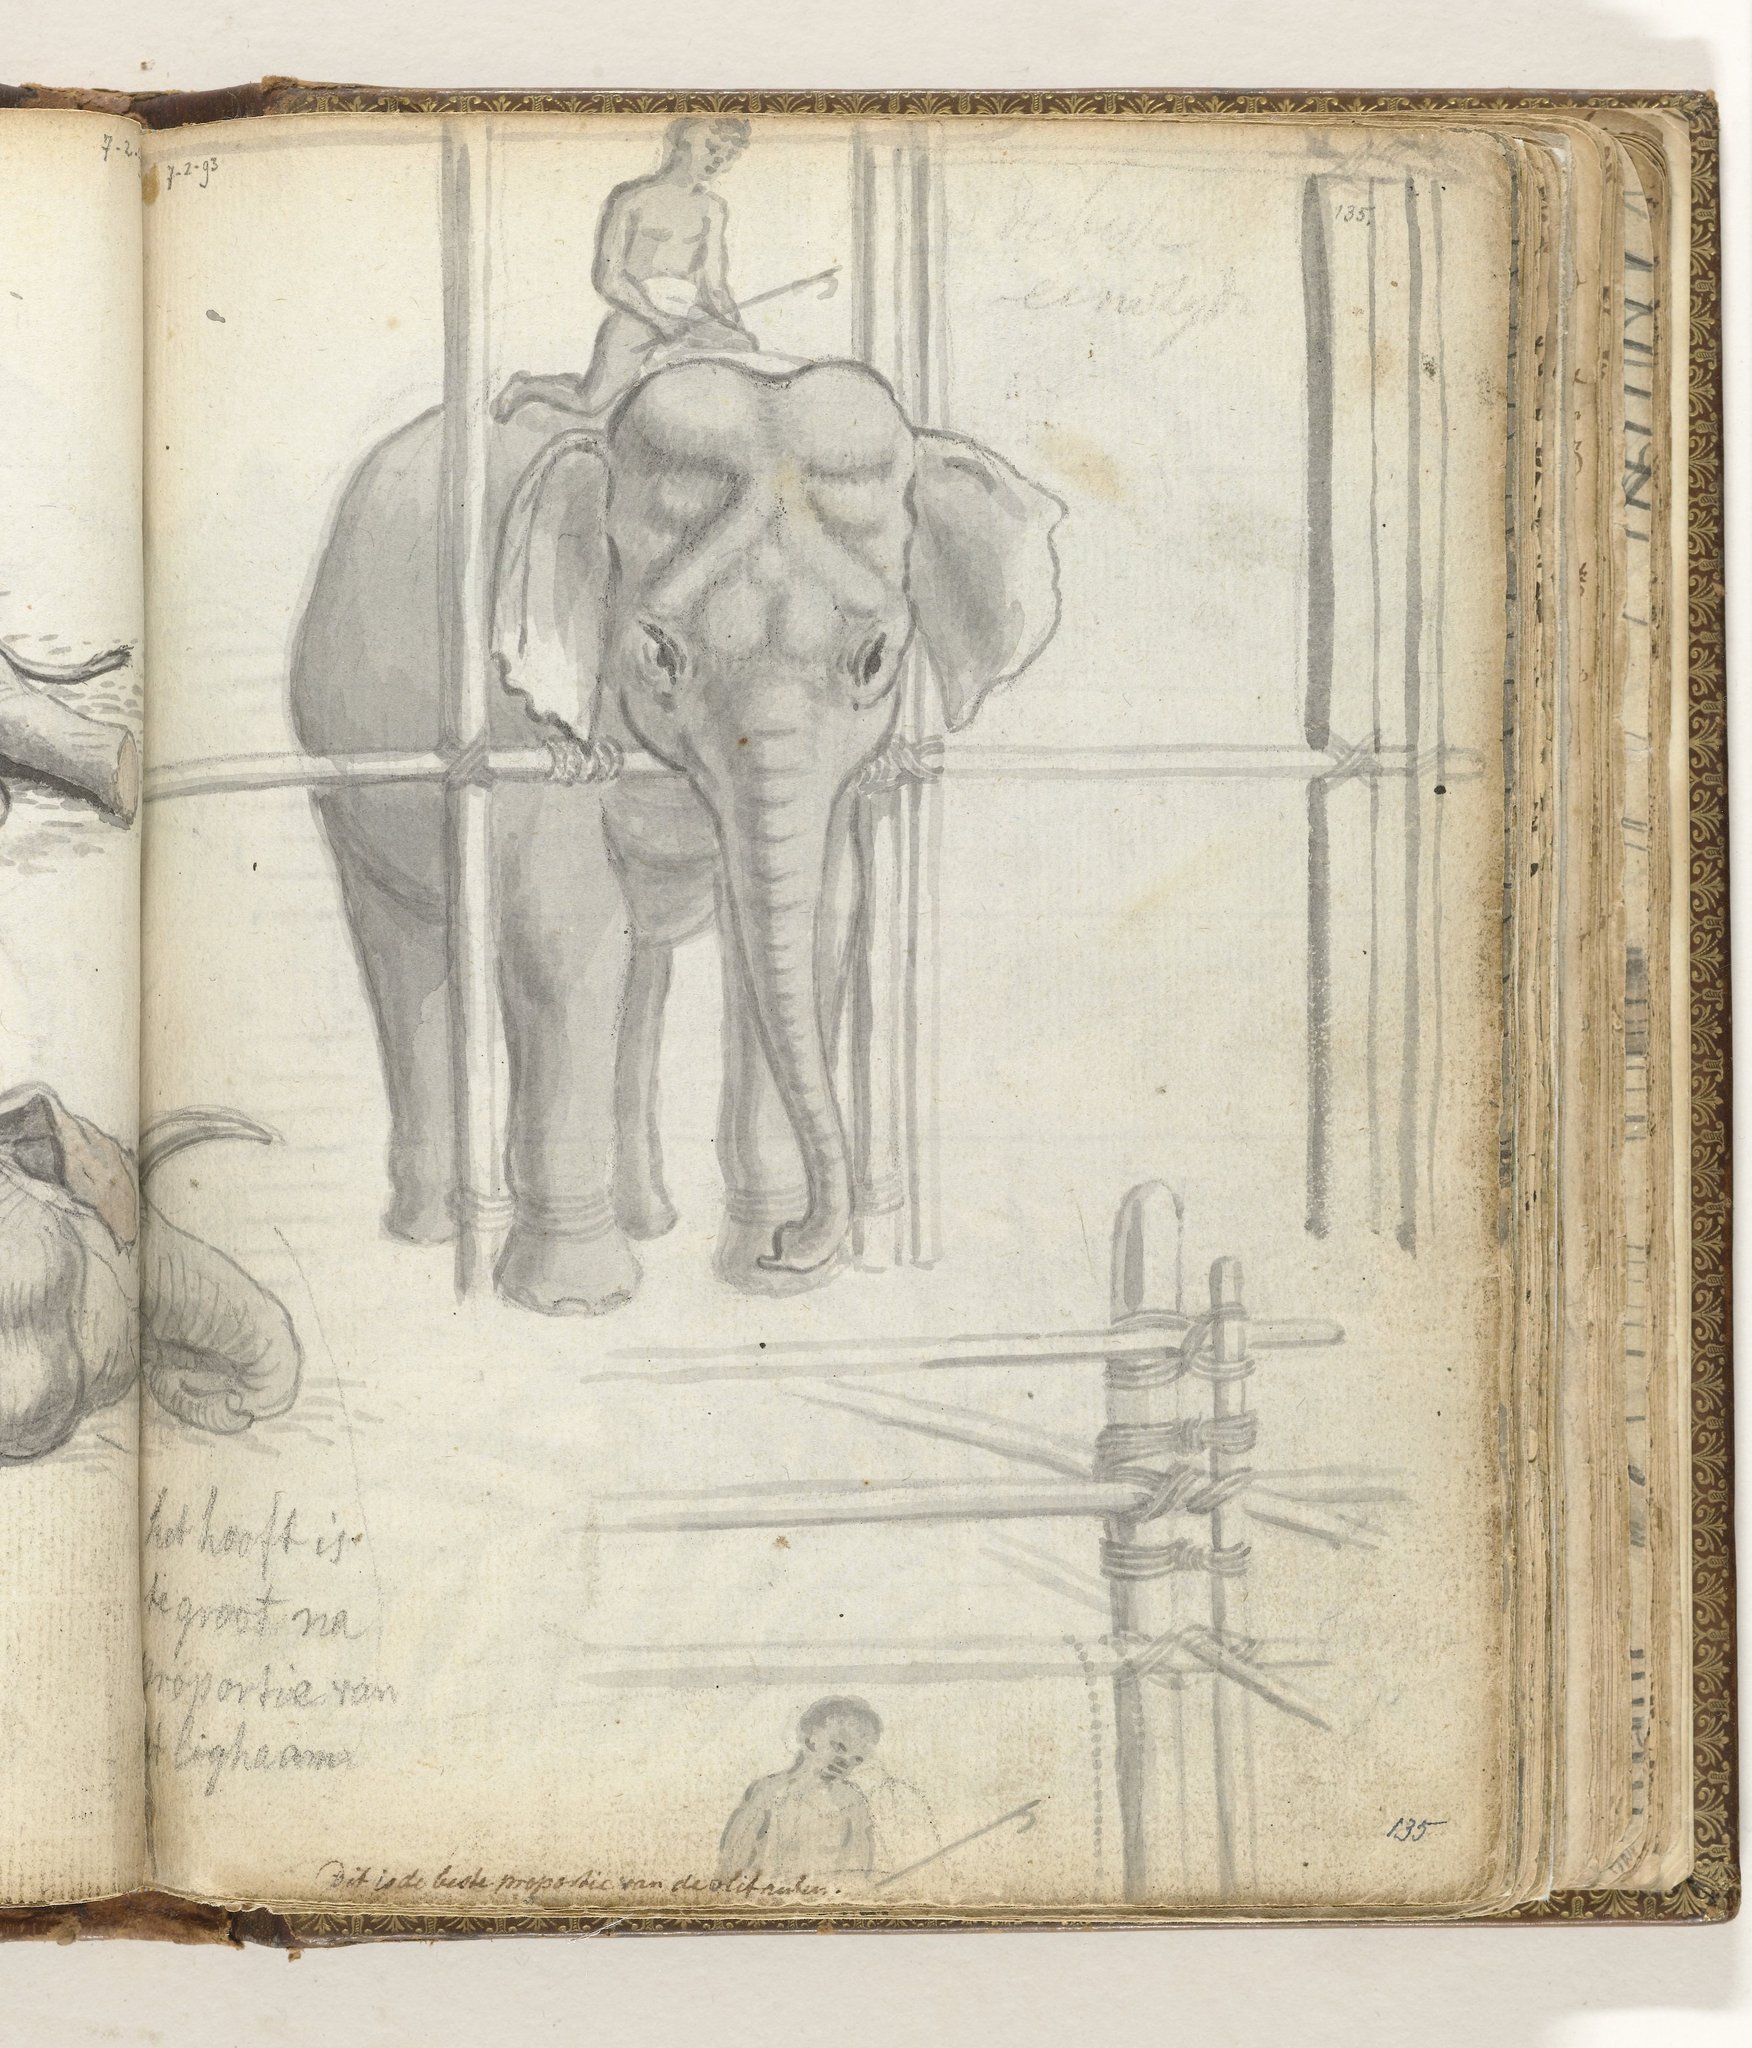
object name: drawing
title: Olifantsstal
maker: jan brandes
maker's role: draughtsman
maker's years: 1743-1808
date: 1712-1785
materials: ink, paper, pencil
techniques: brush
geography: ja-ela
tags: trunked animals: elephant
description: Zwartwitte penseeltekening van een olifantsstal, een bamboe raamwerk. Touwwoelingen om bamboe. Singalees met piek. Met opschrift. Onderdeel uit het schetsboek van Jan Brandes, dl. 2 (1808), p. 135.